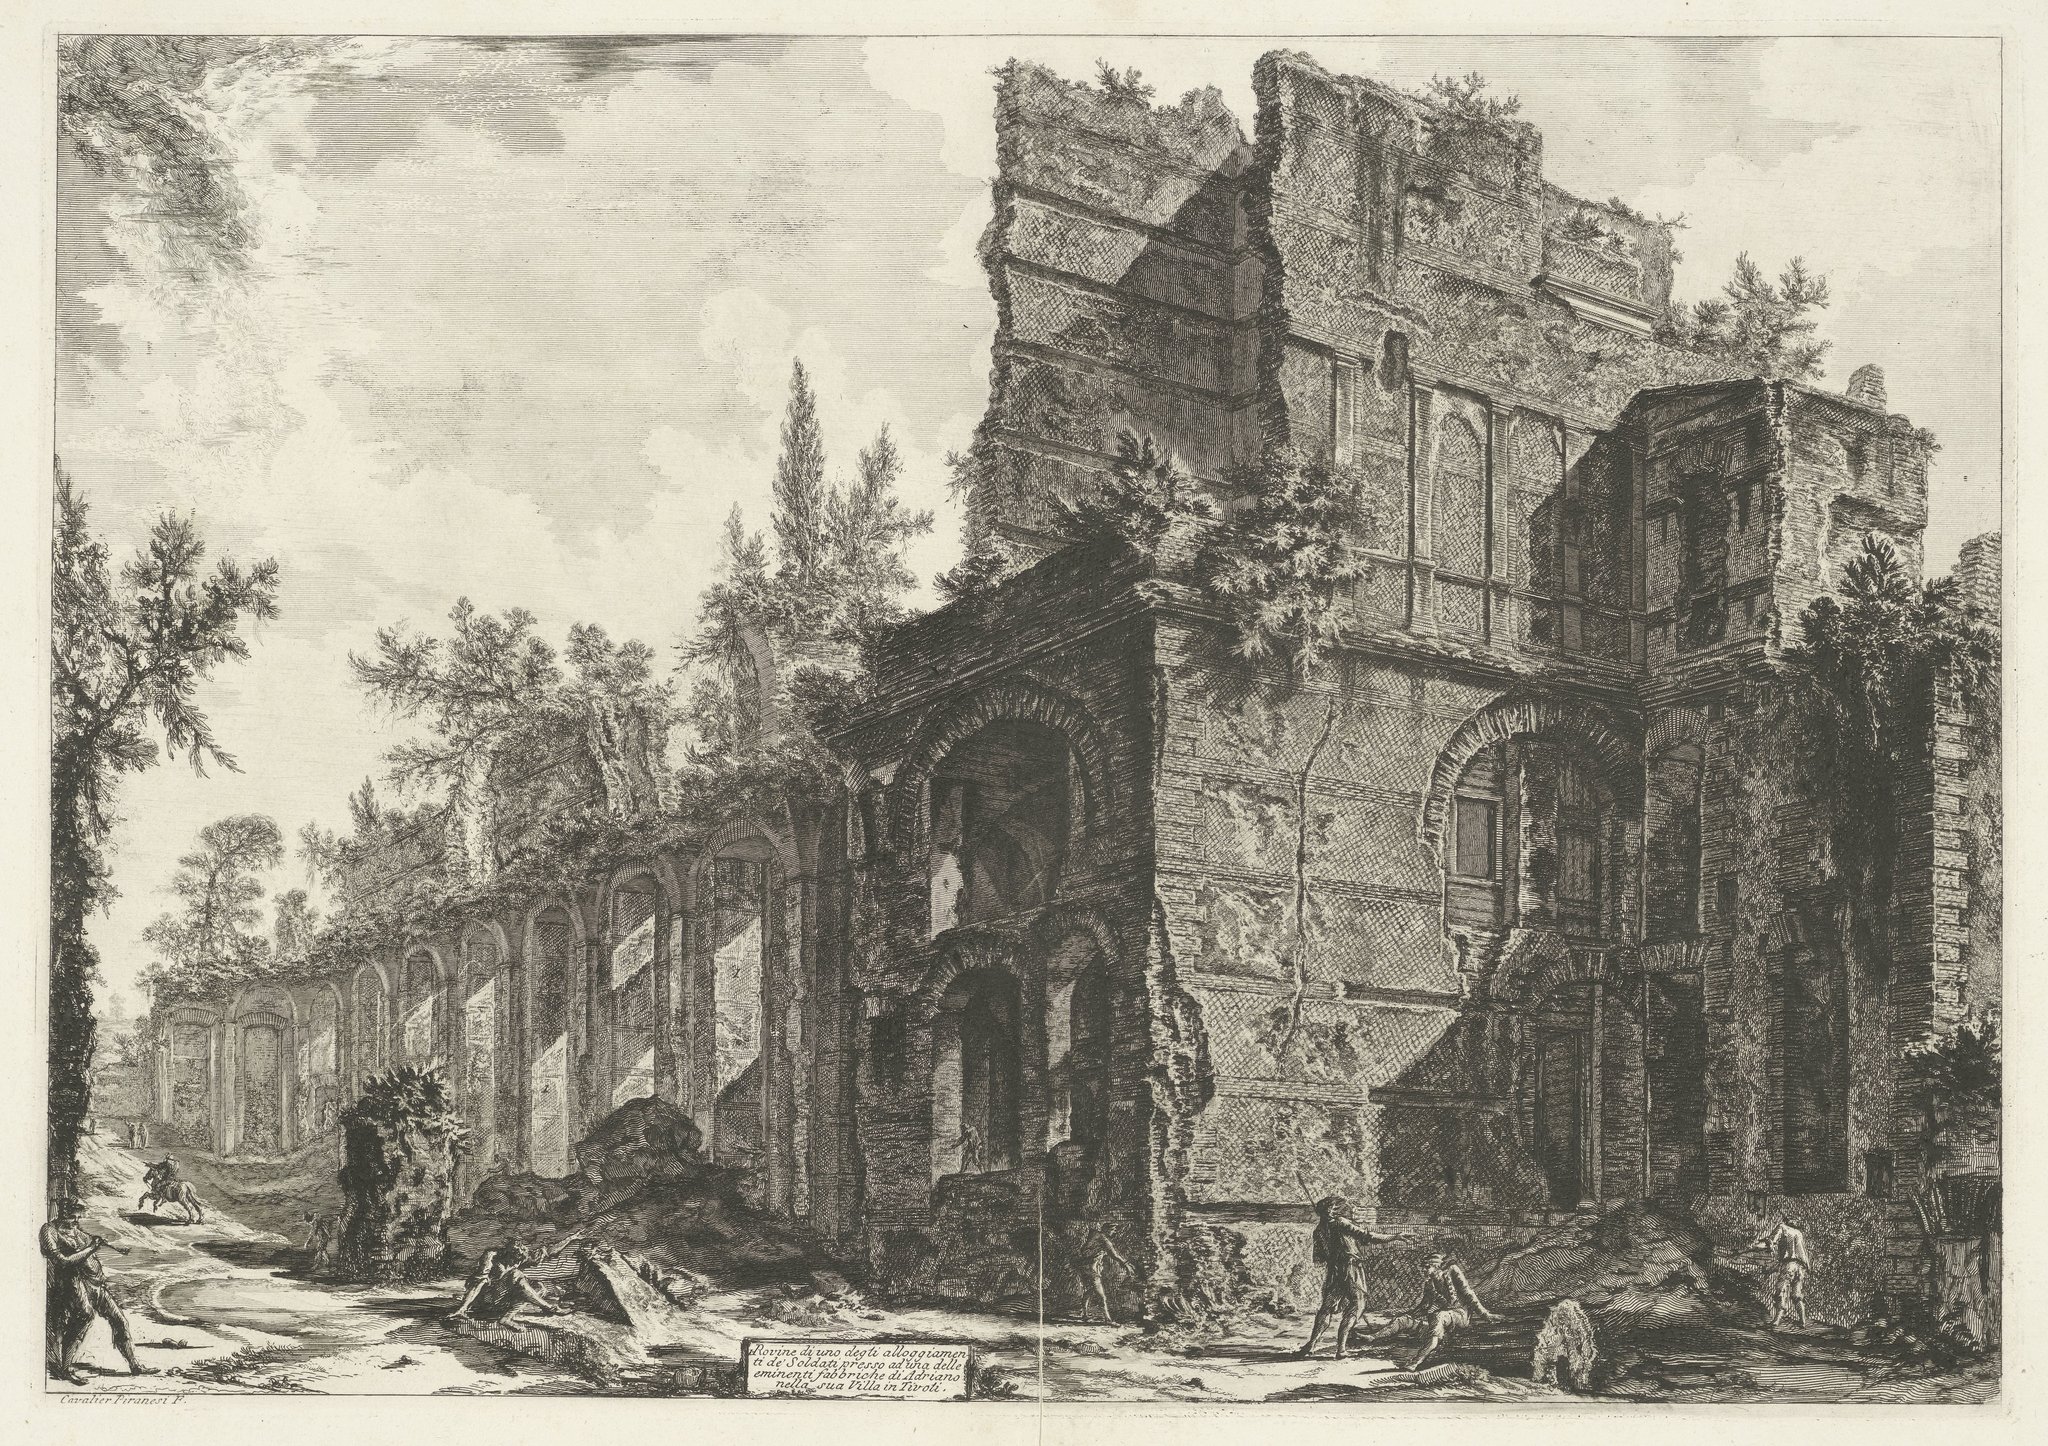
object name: print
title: Gezichten op Rome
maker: giovanni battista piranesi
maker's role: designer, draughtsman, print maker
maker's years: 1720-1778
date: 1748-1778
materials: paper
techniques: etching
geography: rome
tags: villa - aa - civic architecture: inside, landscape with ruins, tivoli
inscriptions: collector's mark: Lugt 2228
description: Deze prent maakt deel uit van de serie 'Vedute di Roma'. Piranesi werkte aan deze 135 platen tellende serie tussen 1748 en zijn dood in 1778. Francesco Piranesi voegde later nog twee prenten toe aan de reeks van zijn vader.